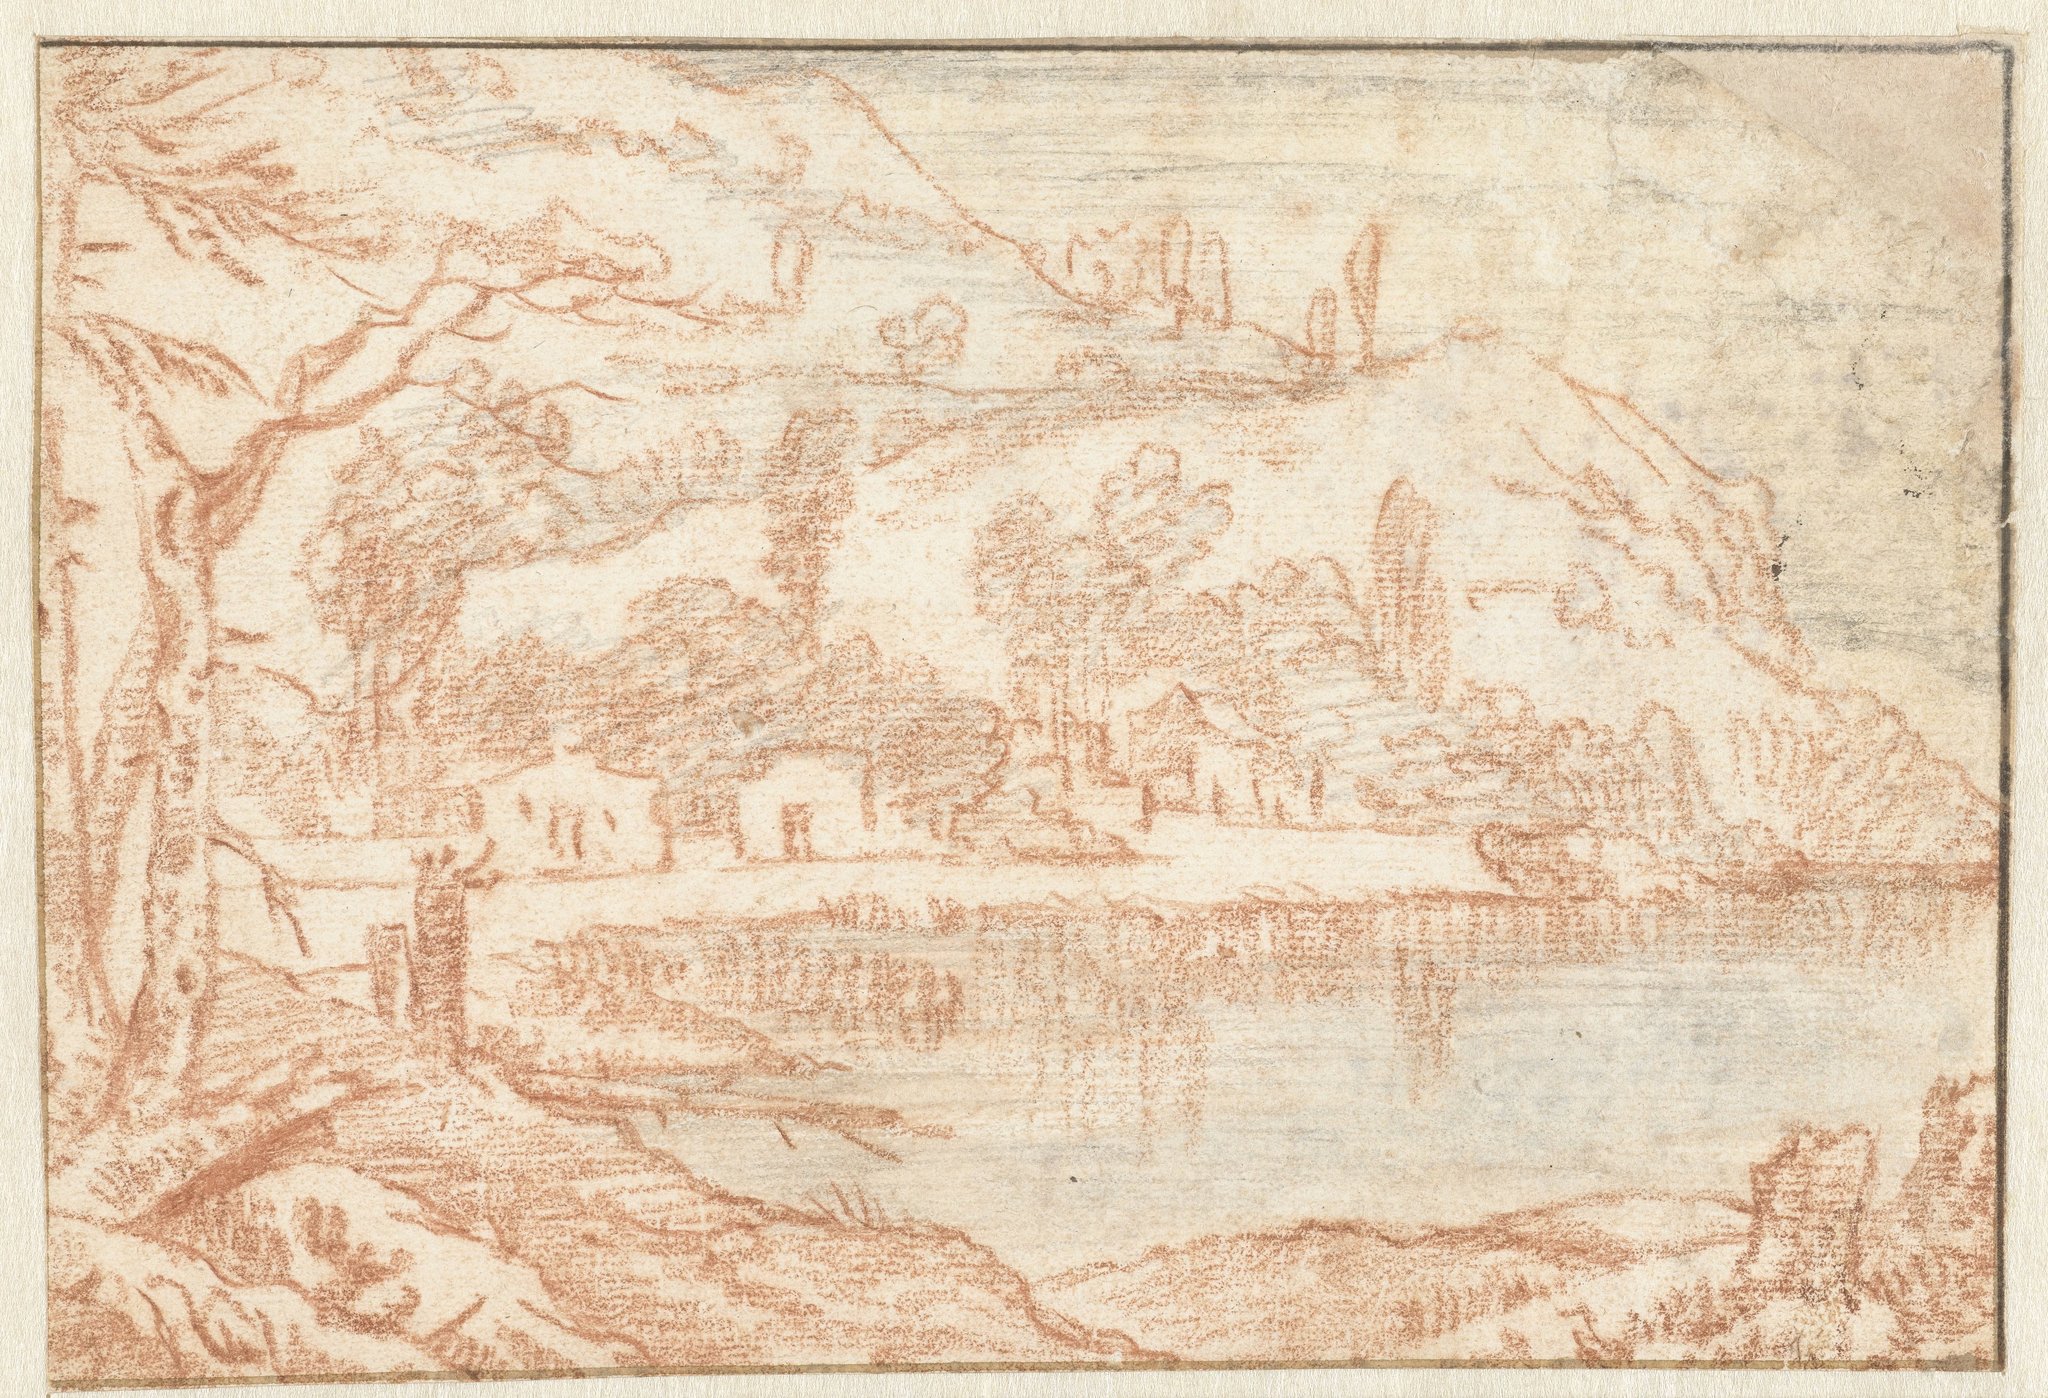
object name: drawing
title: Landschap met een meer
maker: Anonymous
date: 1600-1699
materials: chalk, paper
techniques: brush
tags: landscapes with waters, waterscapes, seascapes (in the temperate zone)